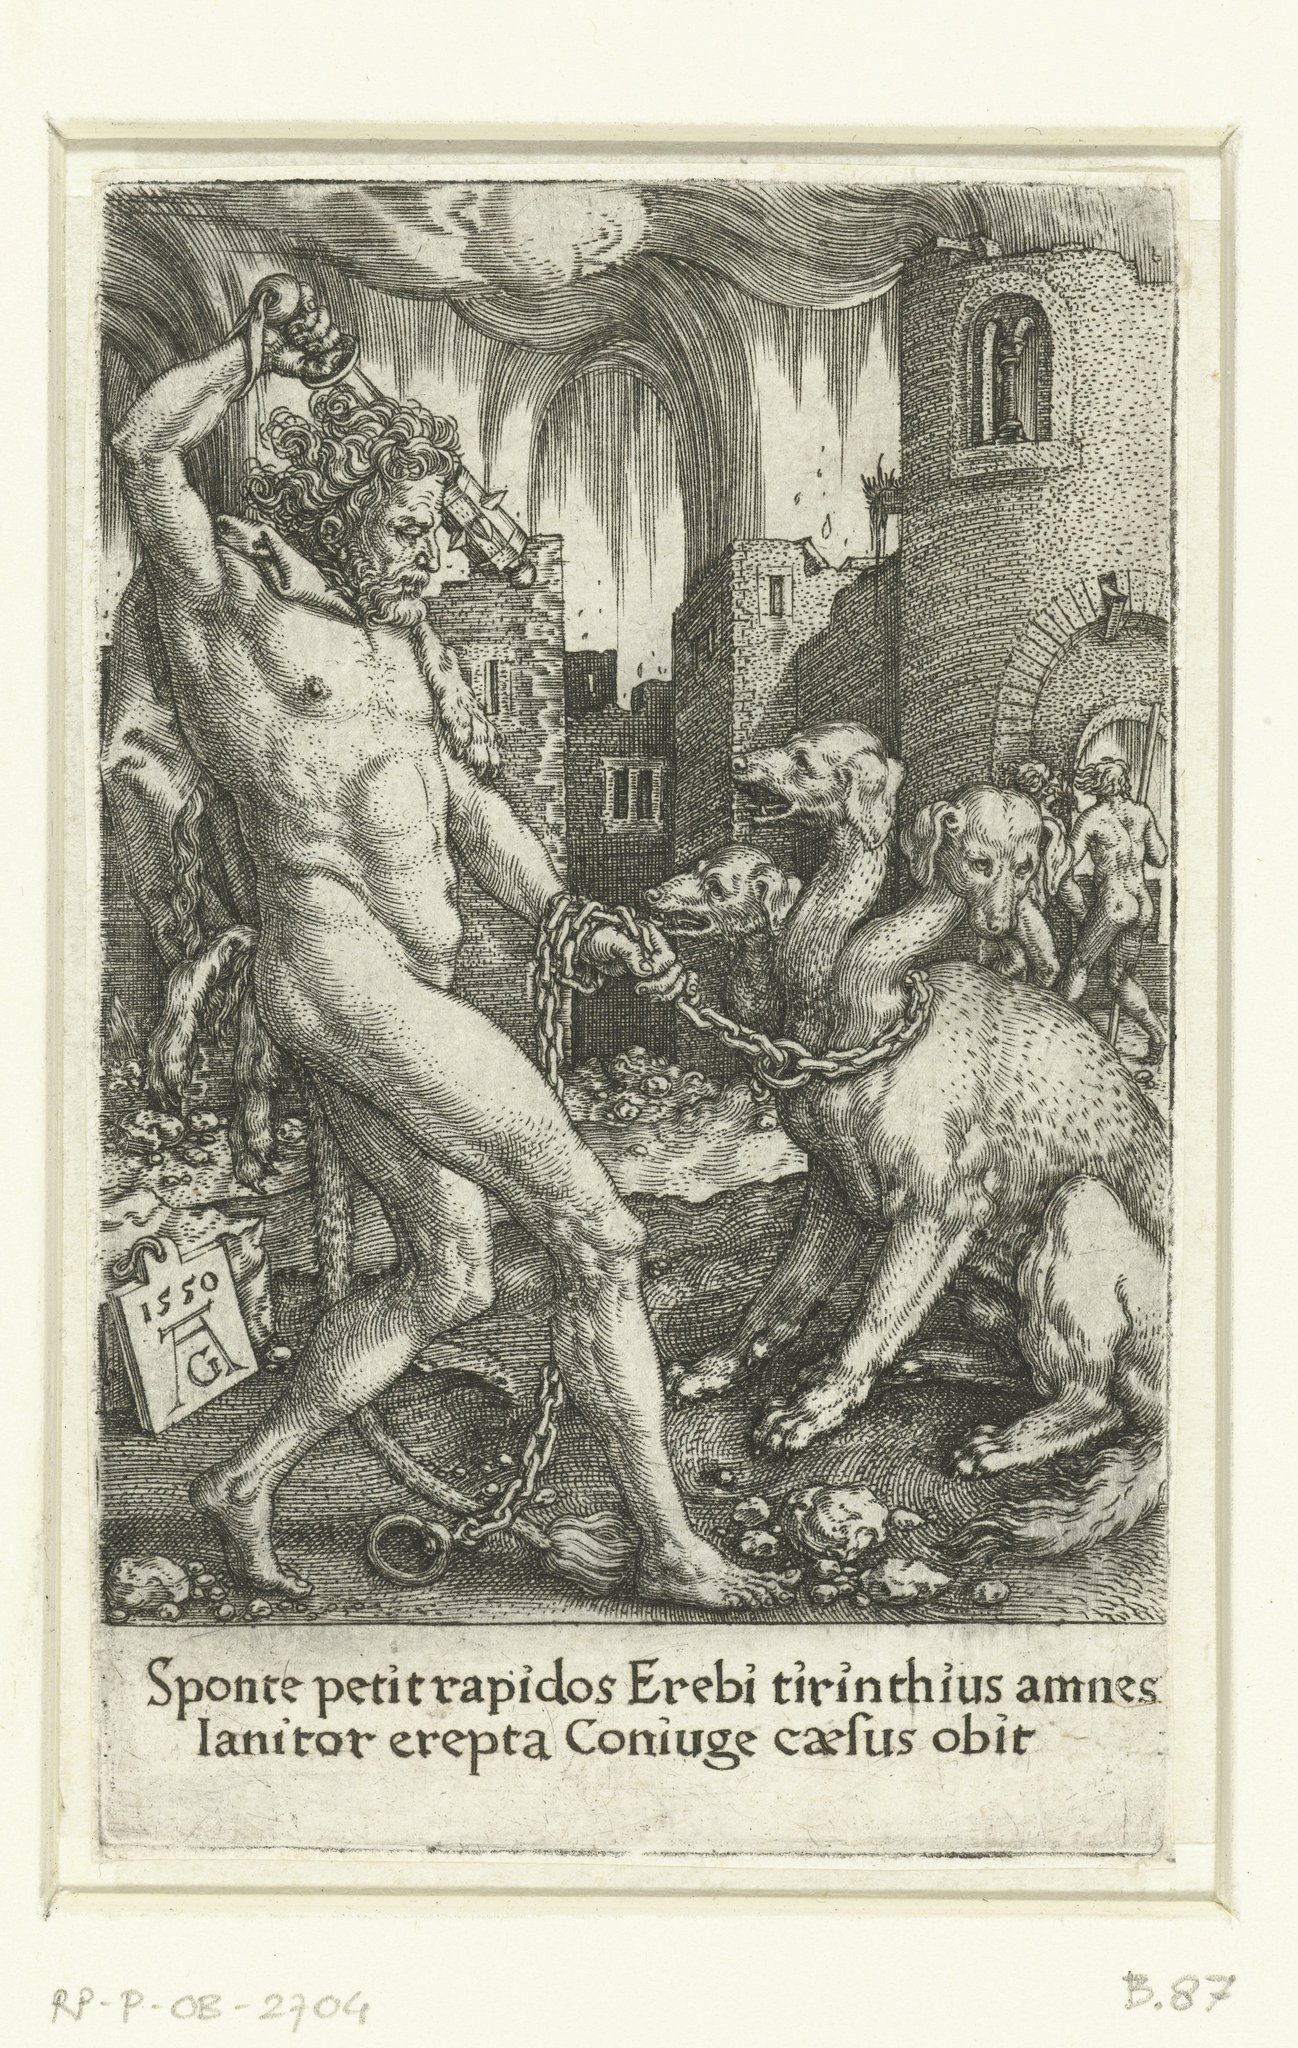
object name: print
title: Werken van Hercules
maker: heinrich aldegrever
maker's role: draughtsman, print maker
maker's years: 1502-1561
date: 1550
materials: paper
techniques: engraving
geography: venice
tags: (12) cerberus captured and carried away by hercules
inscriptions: number: ‘106’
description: Hercules met opgeheven knots, in zijn linkerhand een ketting waaraan het driekoppige monster Cerberus vast zit. Onder de voorstelling een tweeregelige tekst in het Latijn. Vijfde prent uit een serie van dertien met de werken van Hercules.